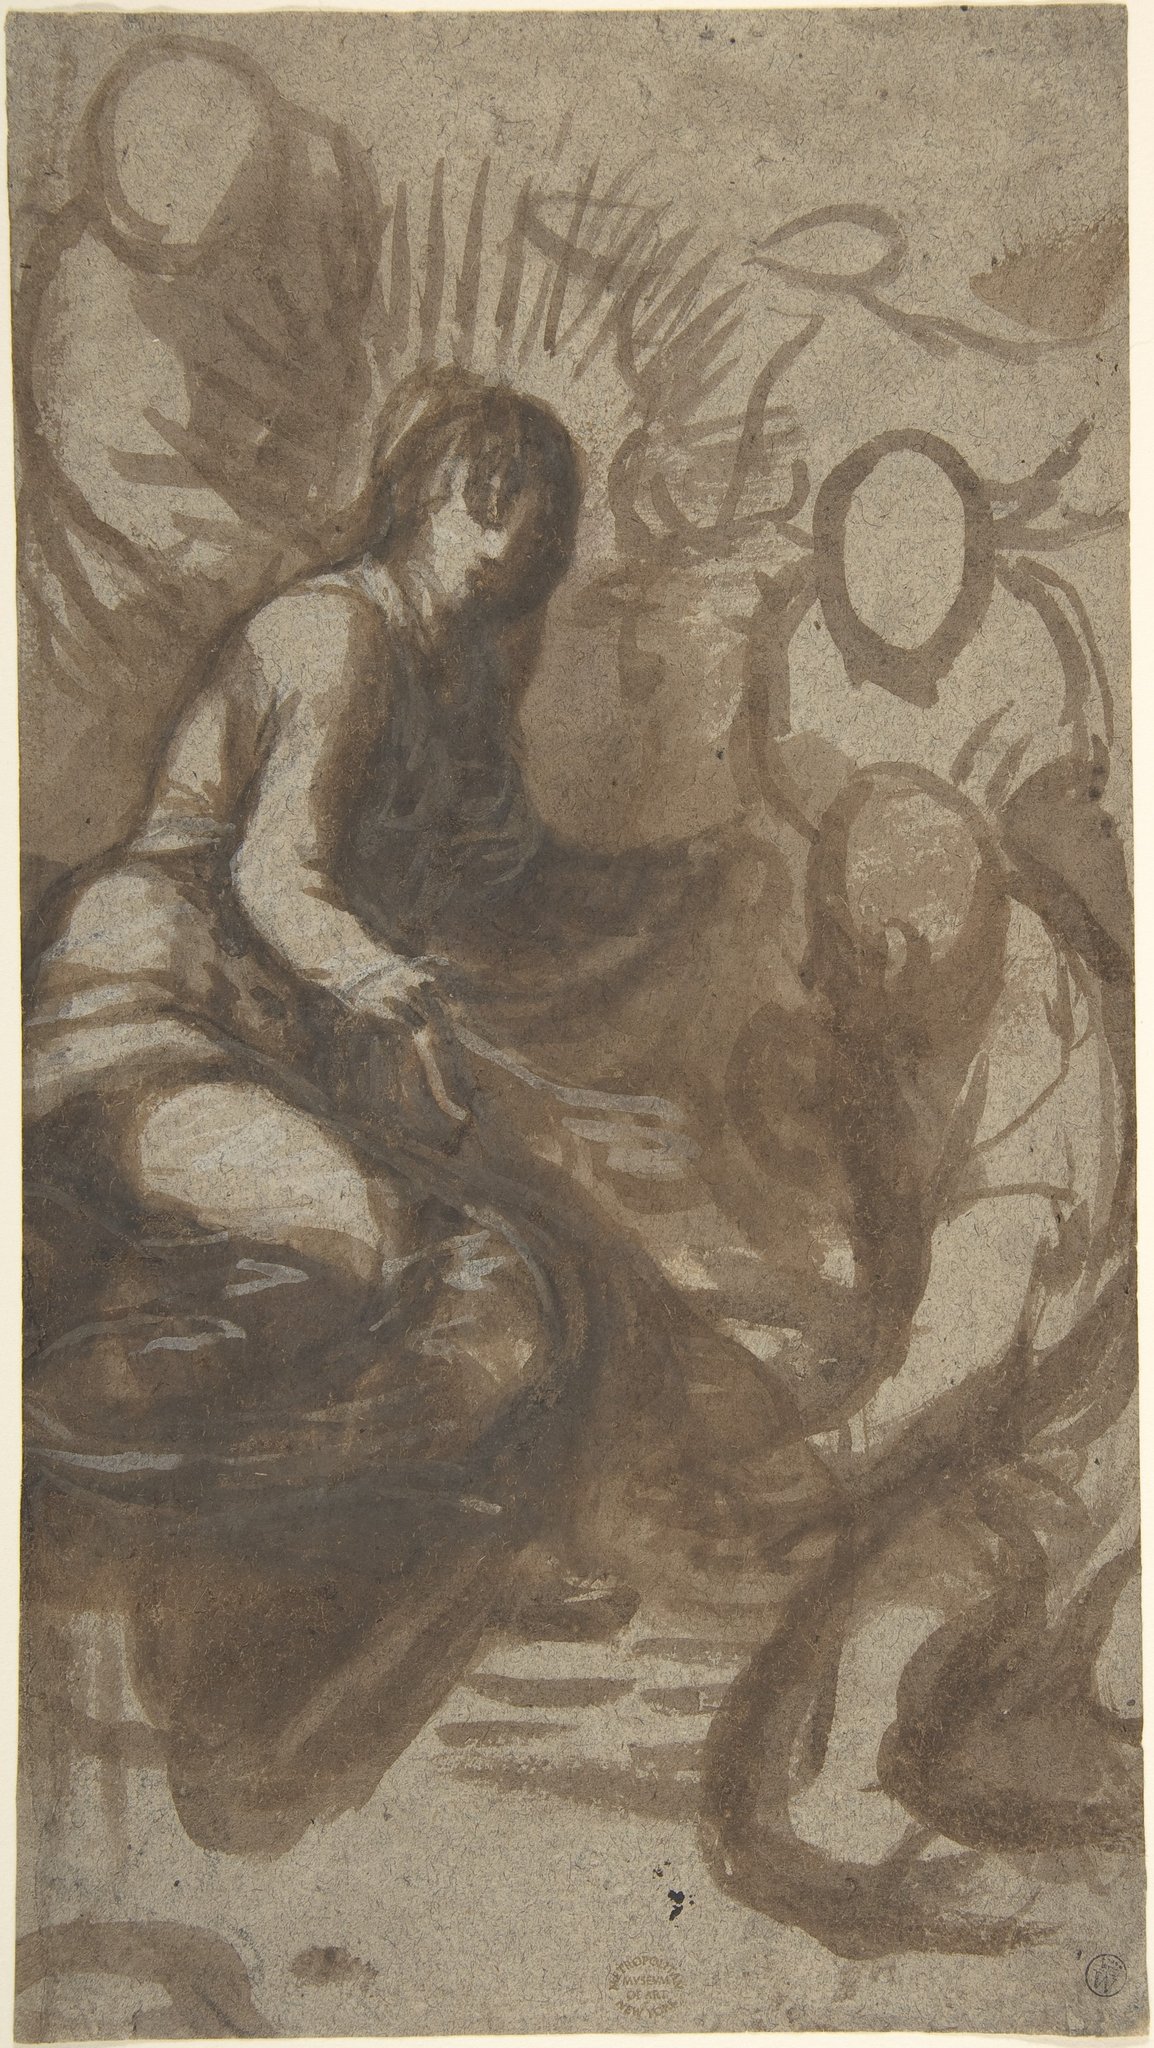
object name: drawing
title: Adoration of the Shepherds(?)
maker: anonymous, italian, 16th century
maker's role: artist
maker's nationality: italian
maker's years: 1550-1600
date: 1501-1600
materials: charcoal, gouache, paper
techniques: brush, highlighting, wash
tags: adoration of the shepherds